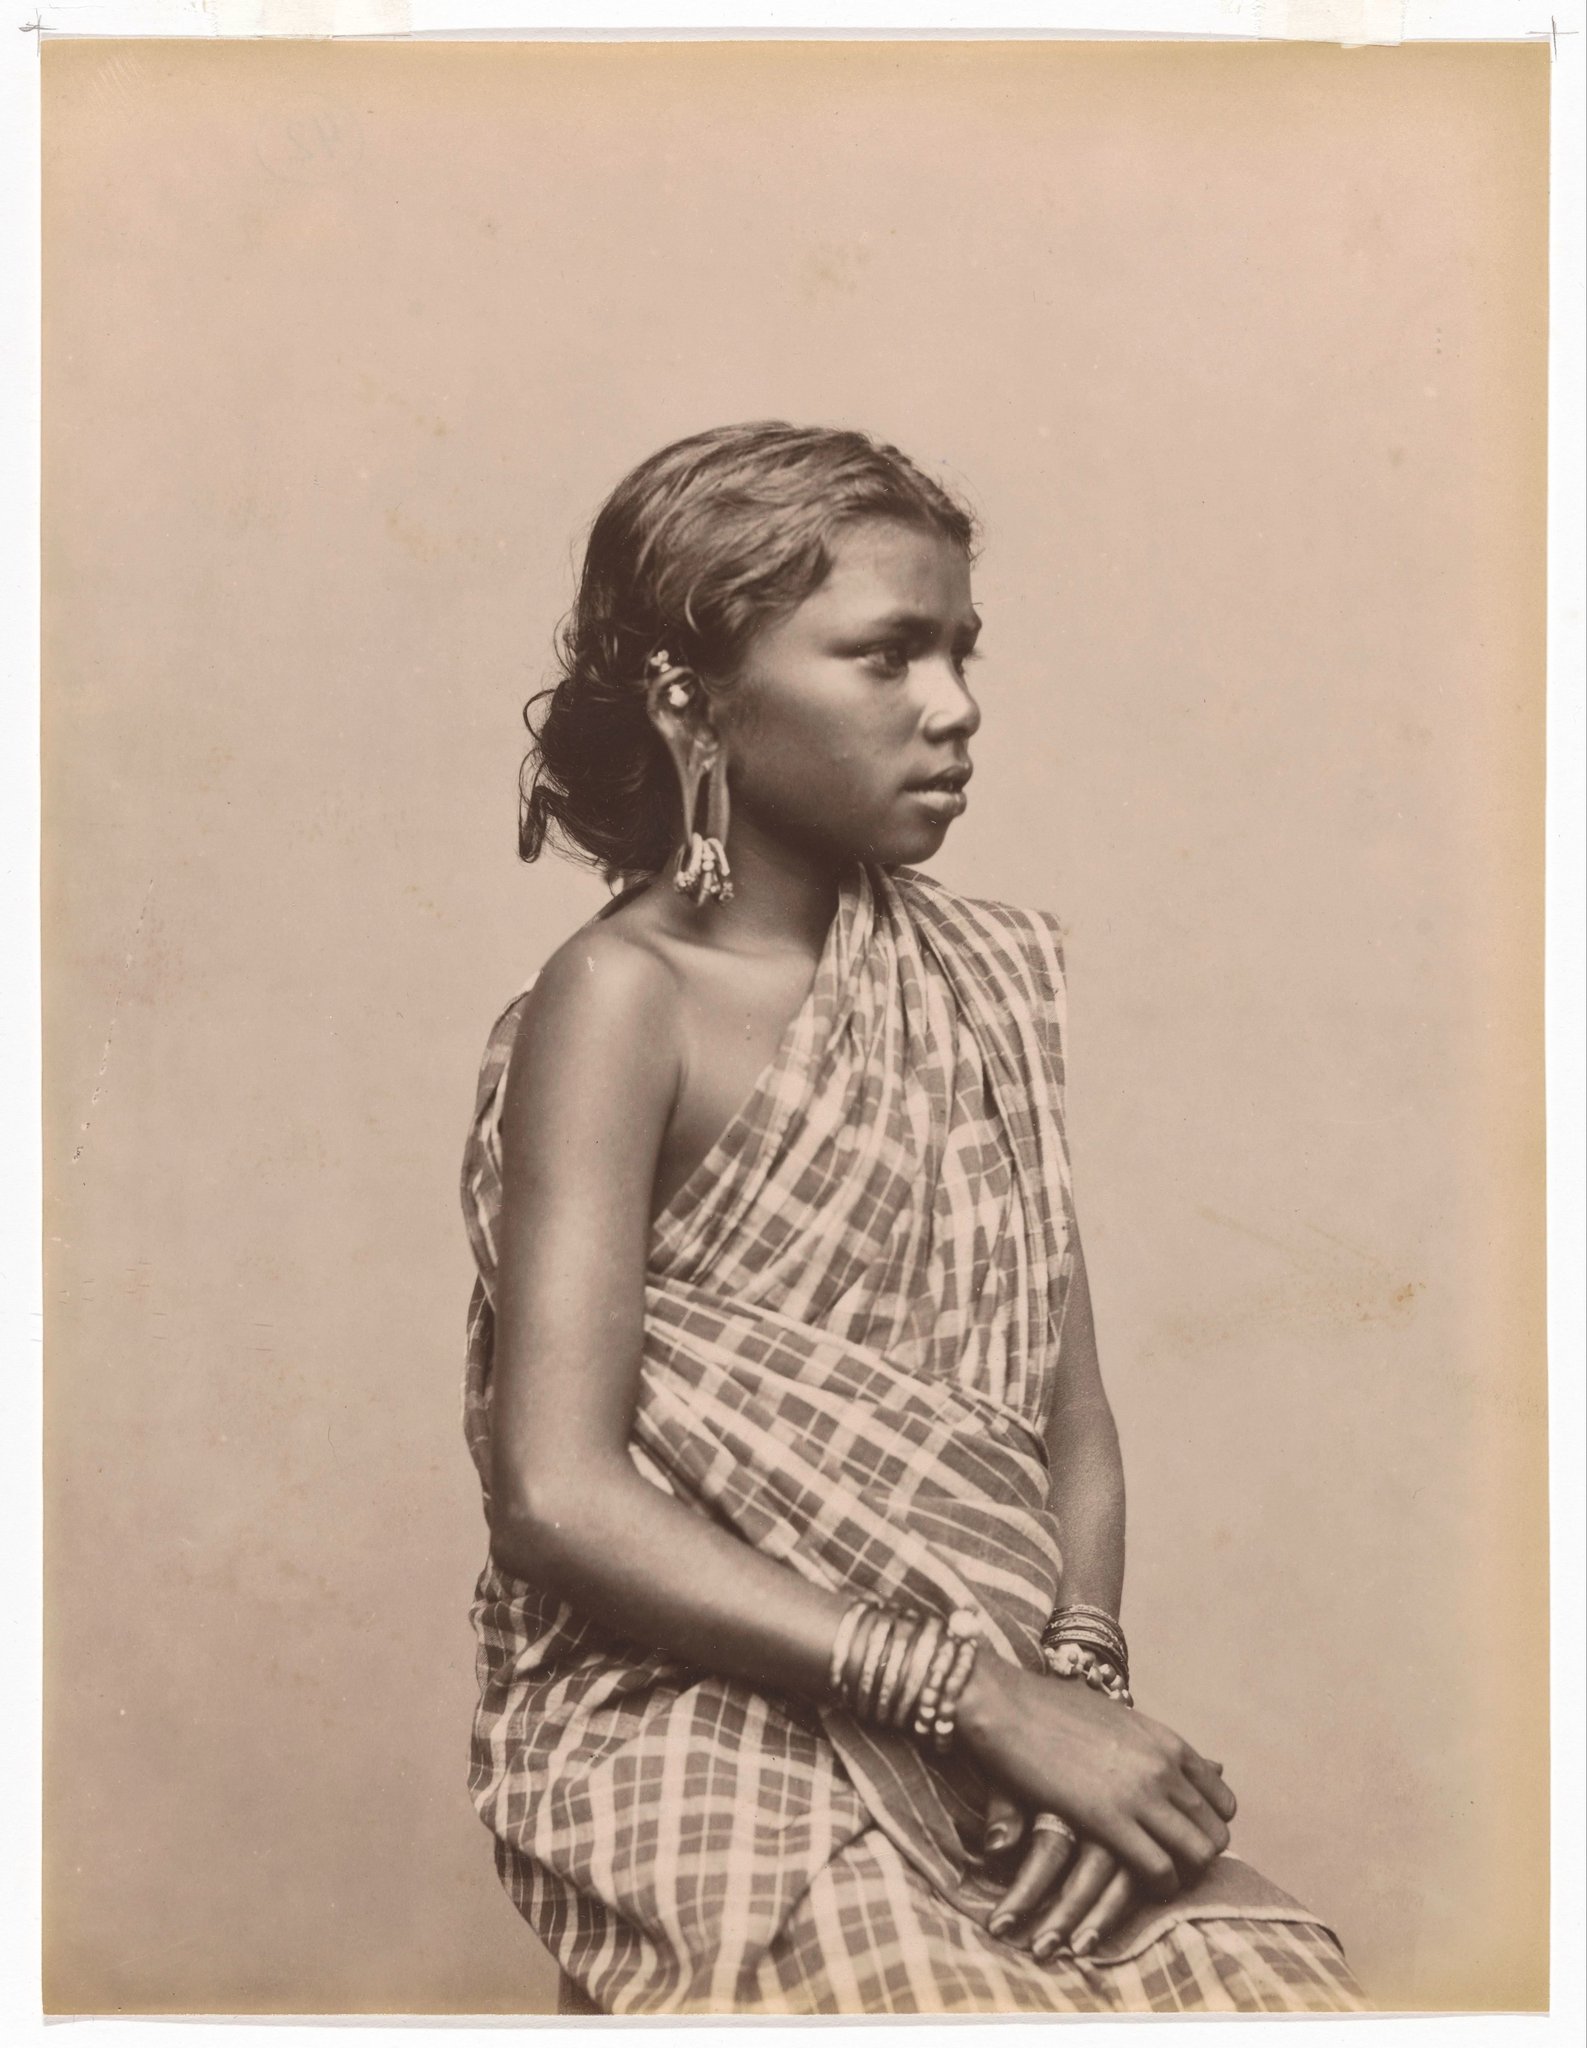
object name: photograph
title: Portrait of an unknown Tamil girl, Sri Lanka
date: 1876-1893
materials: paper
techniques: albumen print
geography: sri lanka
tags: adolescent, young woman, maiden, anonymous historical person portrayed, sri lanka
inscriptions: inscription: ‘Tamil Girl’, number: ‘42’